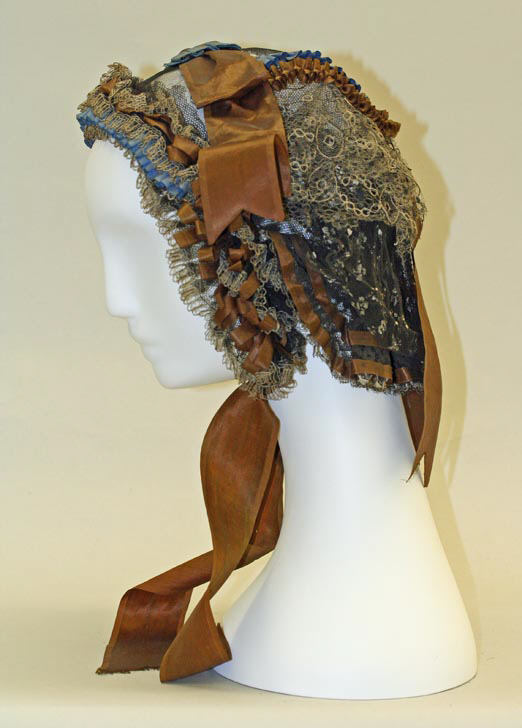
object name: hat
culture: american or european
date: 1864-1865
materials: cotton